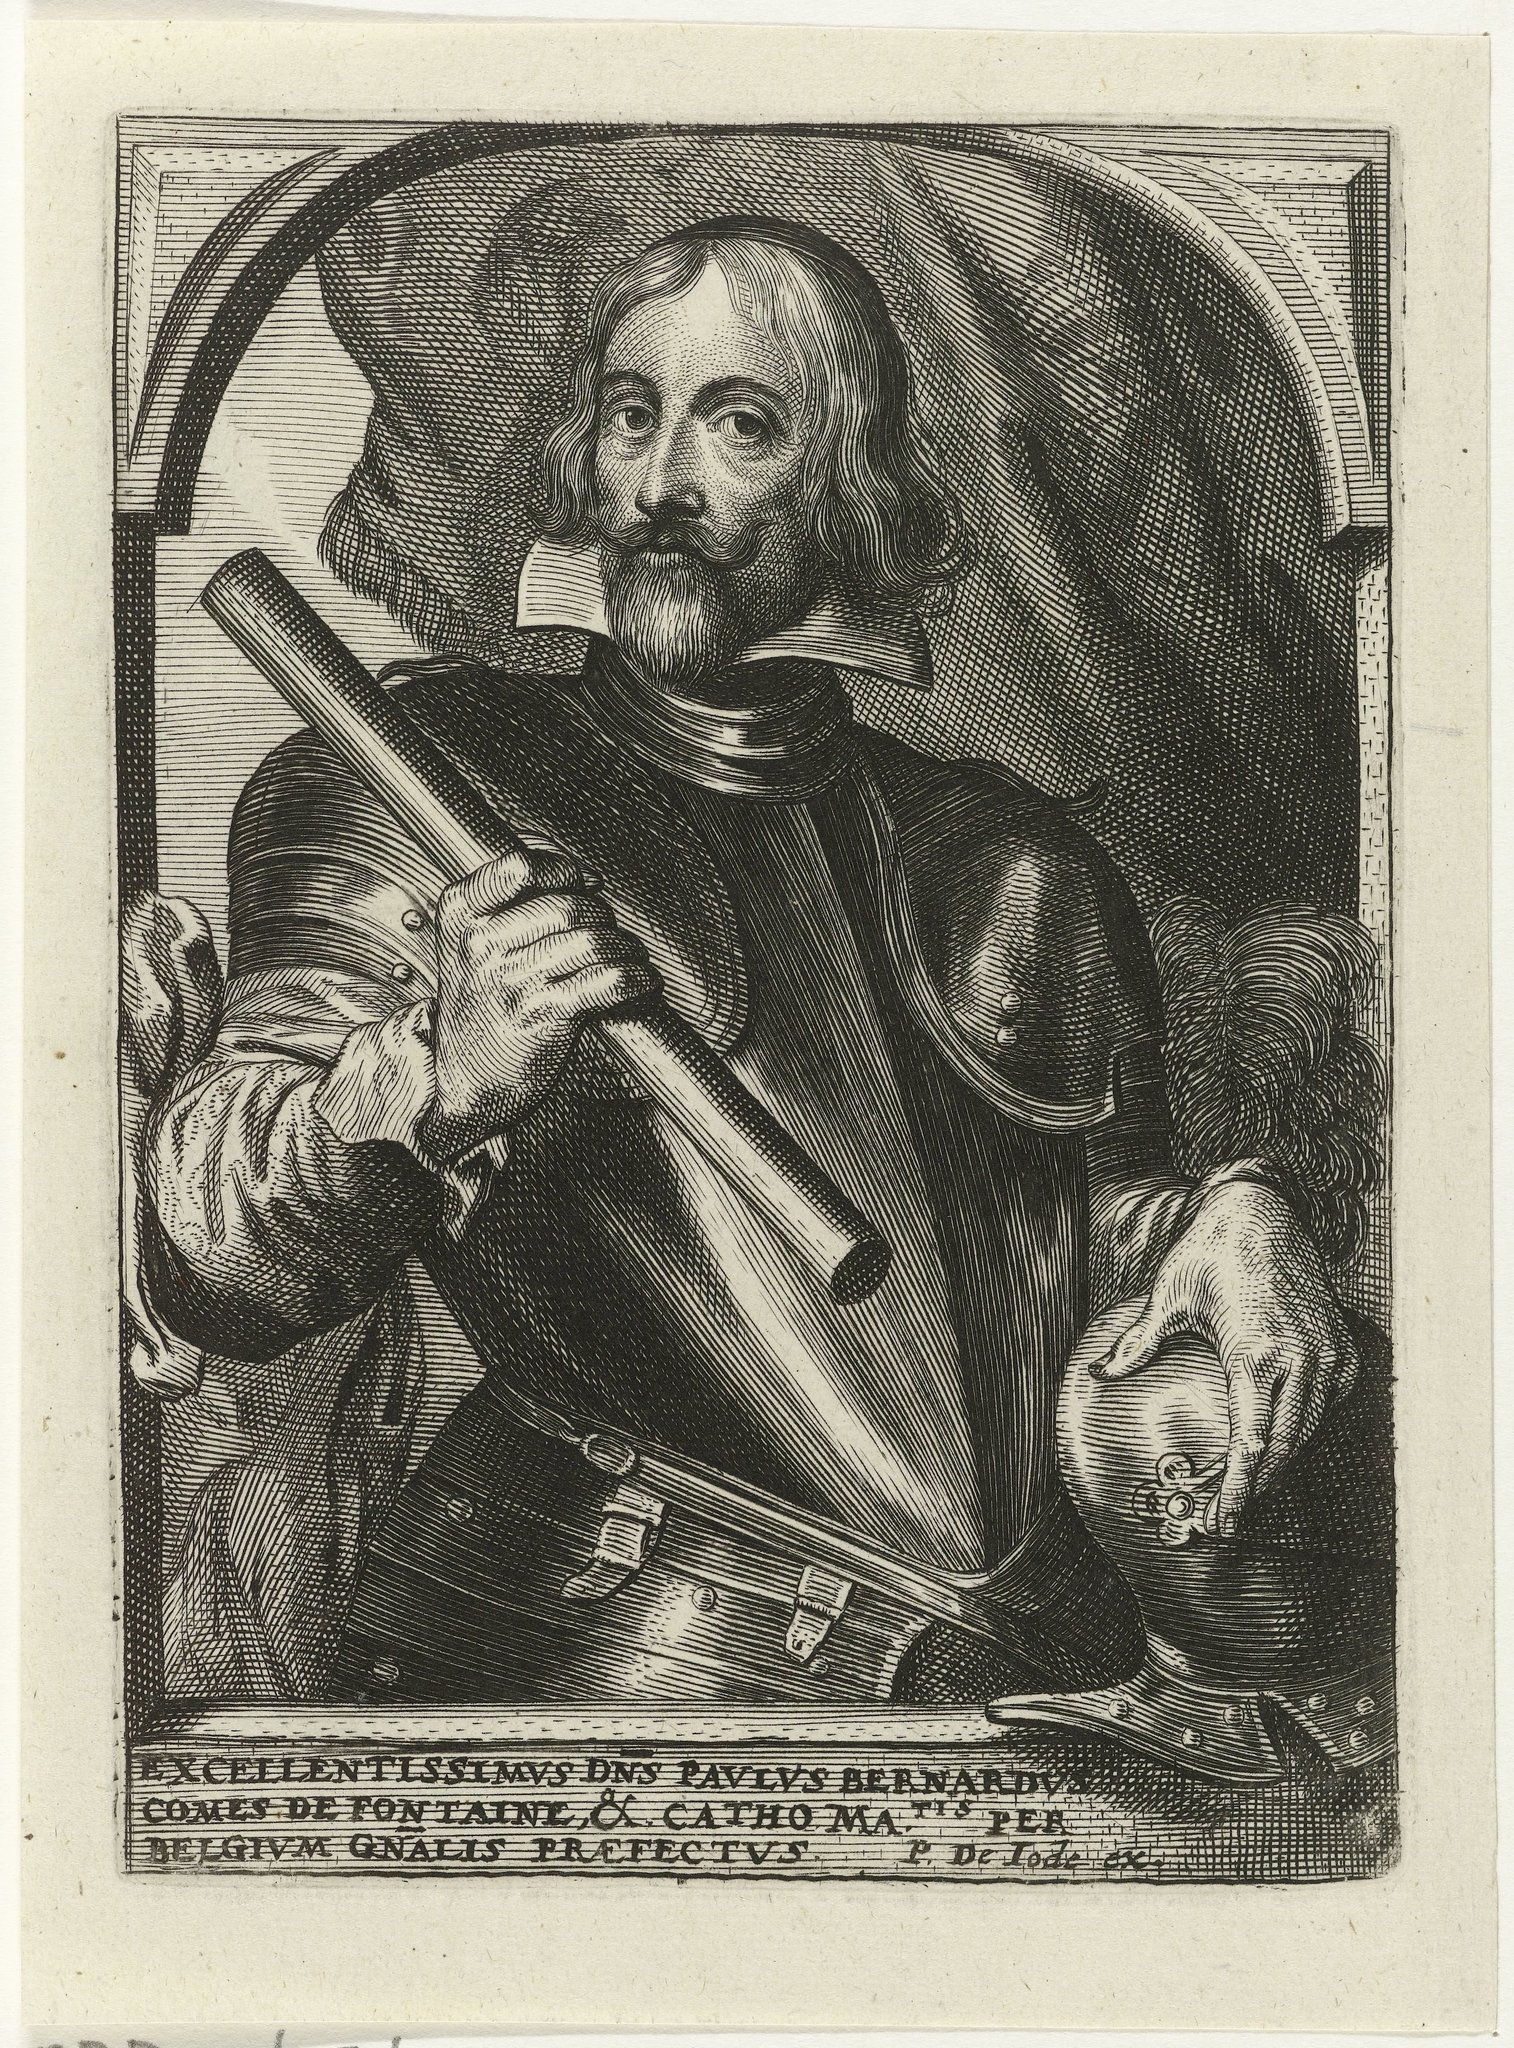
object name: print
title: Portret van Paul-Bernard de Fontaine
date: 1628-1670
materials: paper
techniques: engraving, etching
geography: antwerp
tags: earl, armour, baton of general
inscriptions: collector's mark: Lugt 2228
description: Portret van Paul-Bernard de Fontaine, ten halven lijve. Hij draagt een harnas. In zijn rechterhand houdt hij een commandostaf en zijn linkerhand leunt op zijn helm. Het portret is gevat in een boogvormige omlijsting met een drieregelig onderschrift in het Latijn.